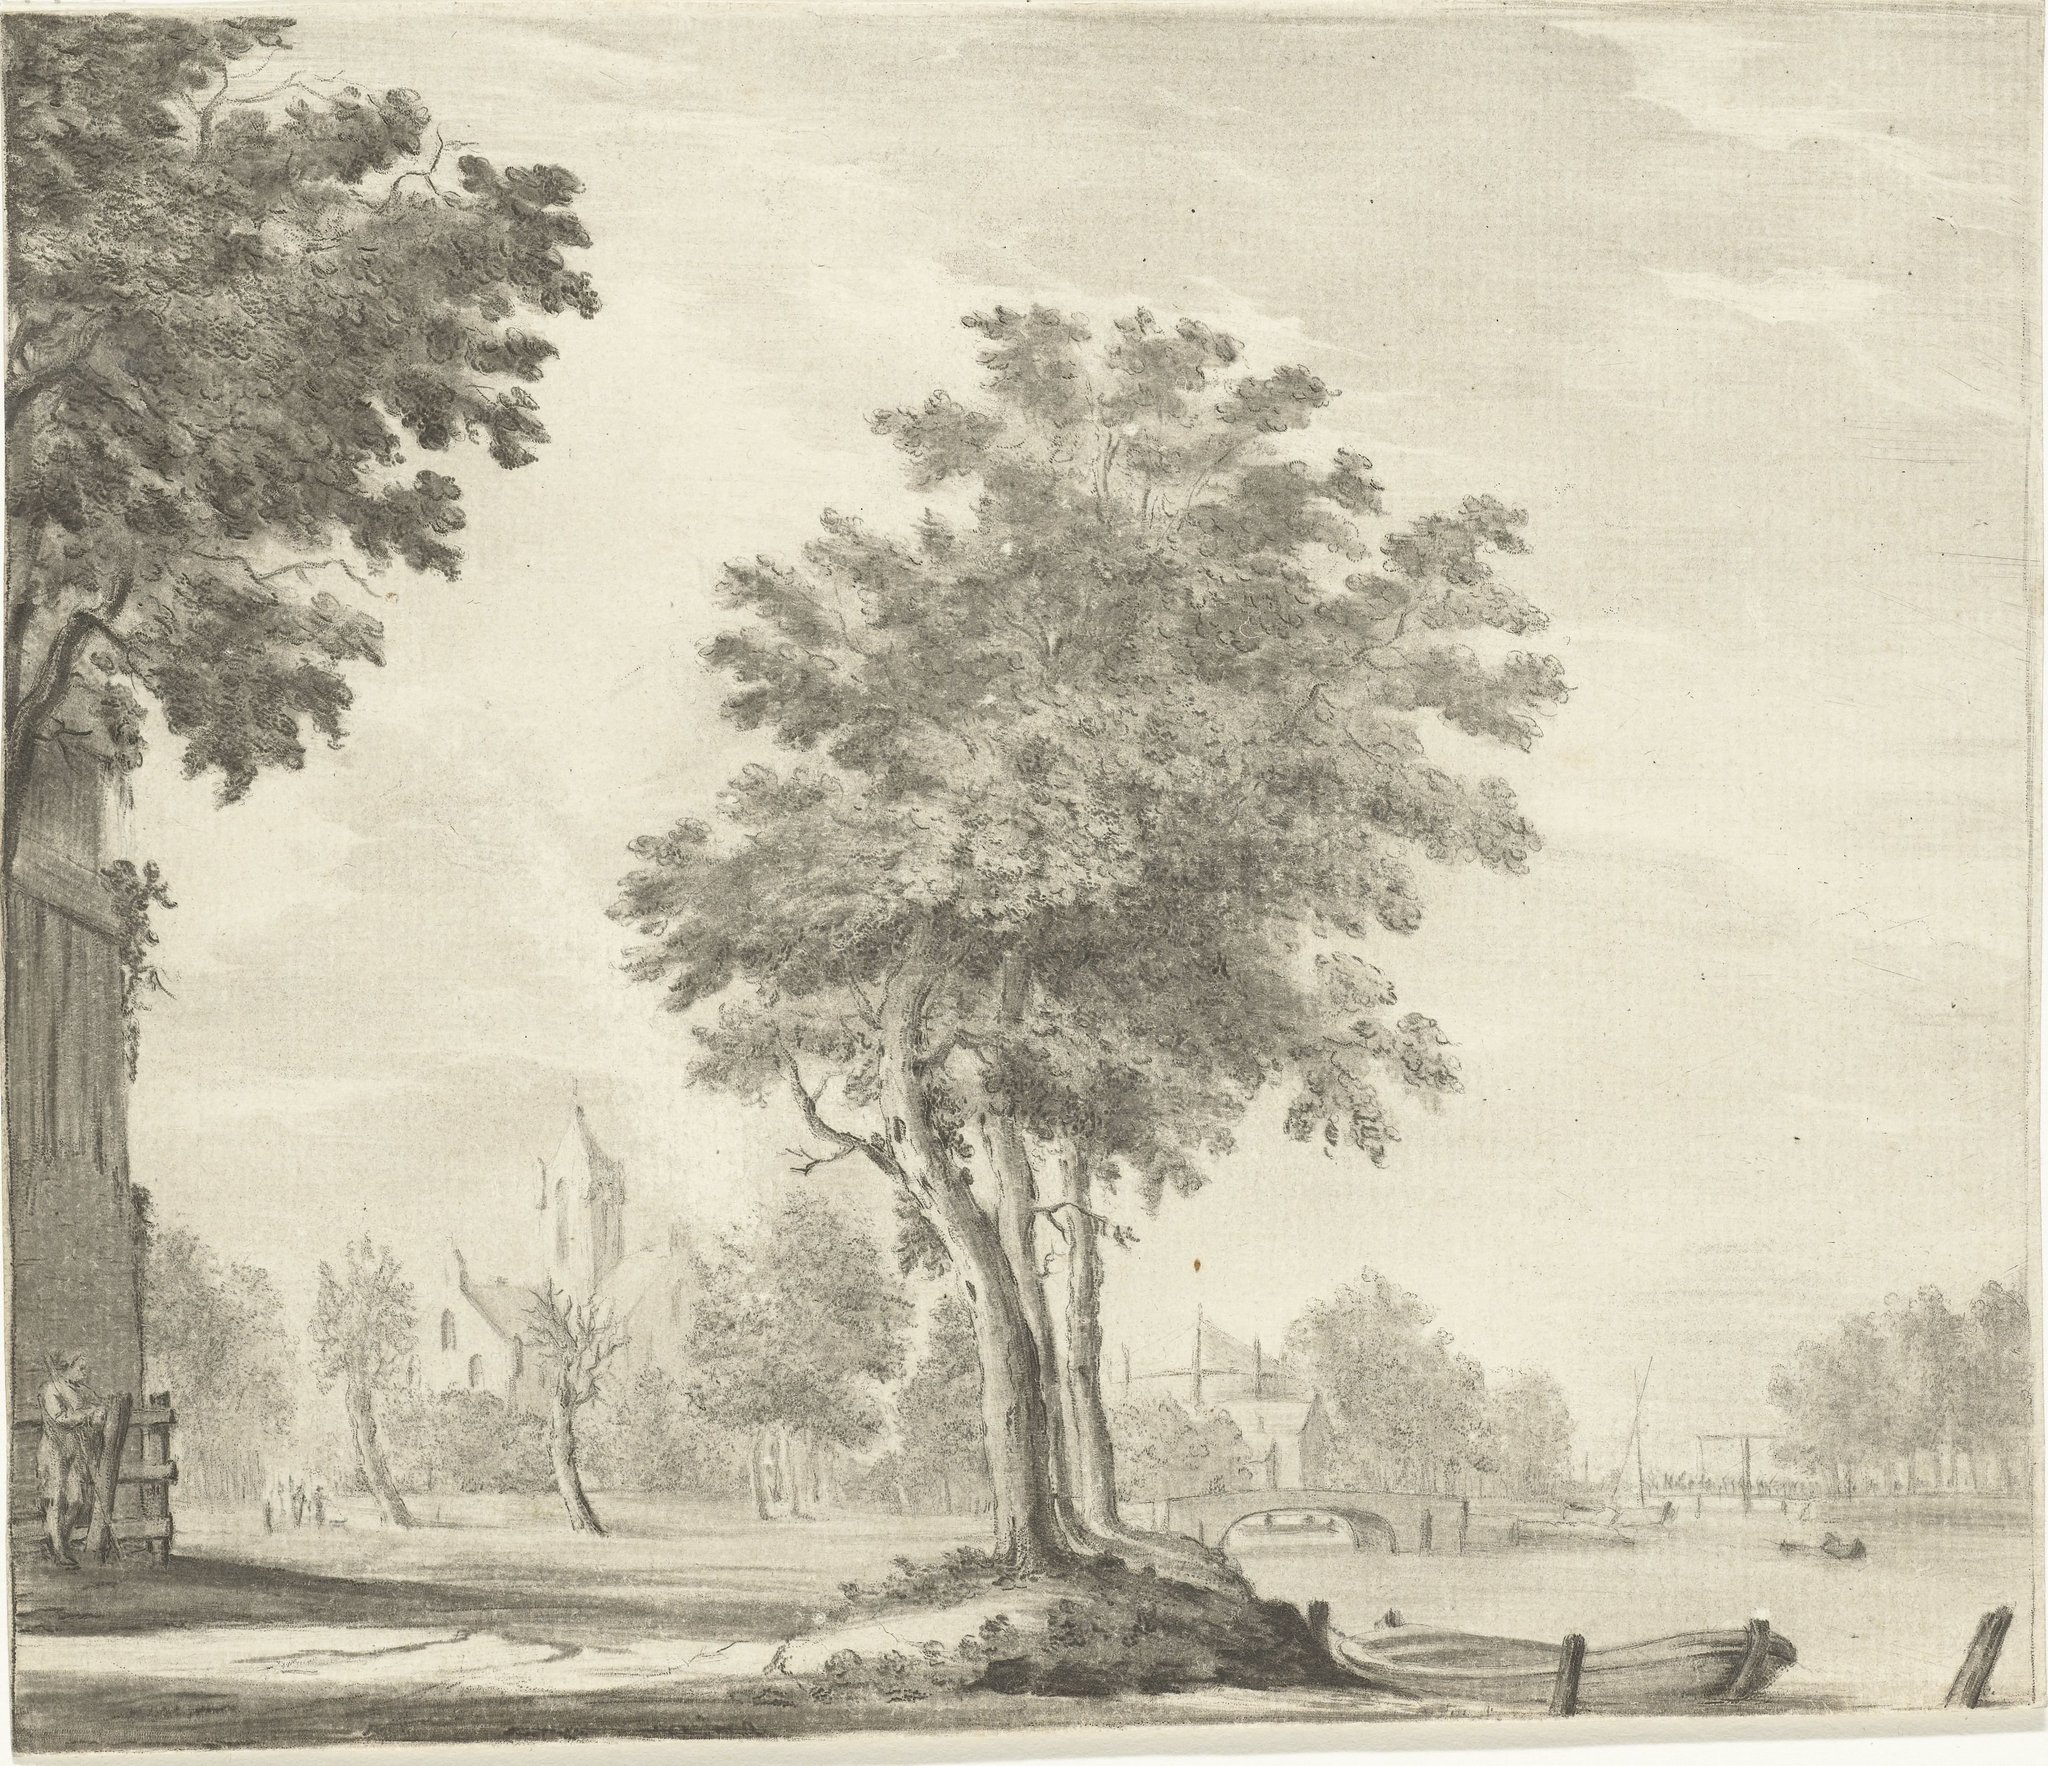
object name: print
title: Gezicht op een dorp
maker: jurriaan cootwijck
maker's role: print maker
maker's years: 1714-1798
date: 1724-1798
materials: paper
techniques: print drawing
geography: amsterdam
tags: trees, village (+ city(-scape) with figures, staffage), bridge in village across river, canal, etc.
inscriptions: collector's mark: Lugt 2228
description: Gezicht op een dorp. Het dorp ligt aan een rivier. Op de achtergrond de kerk. Op de voorgrond drie hoge bomen.